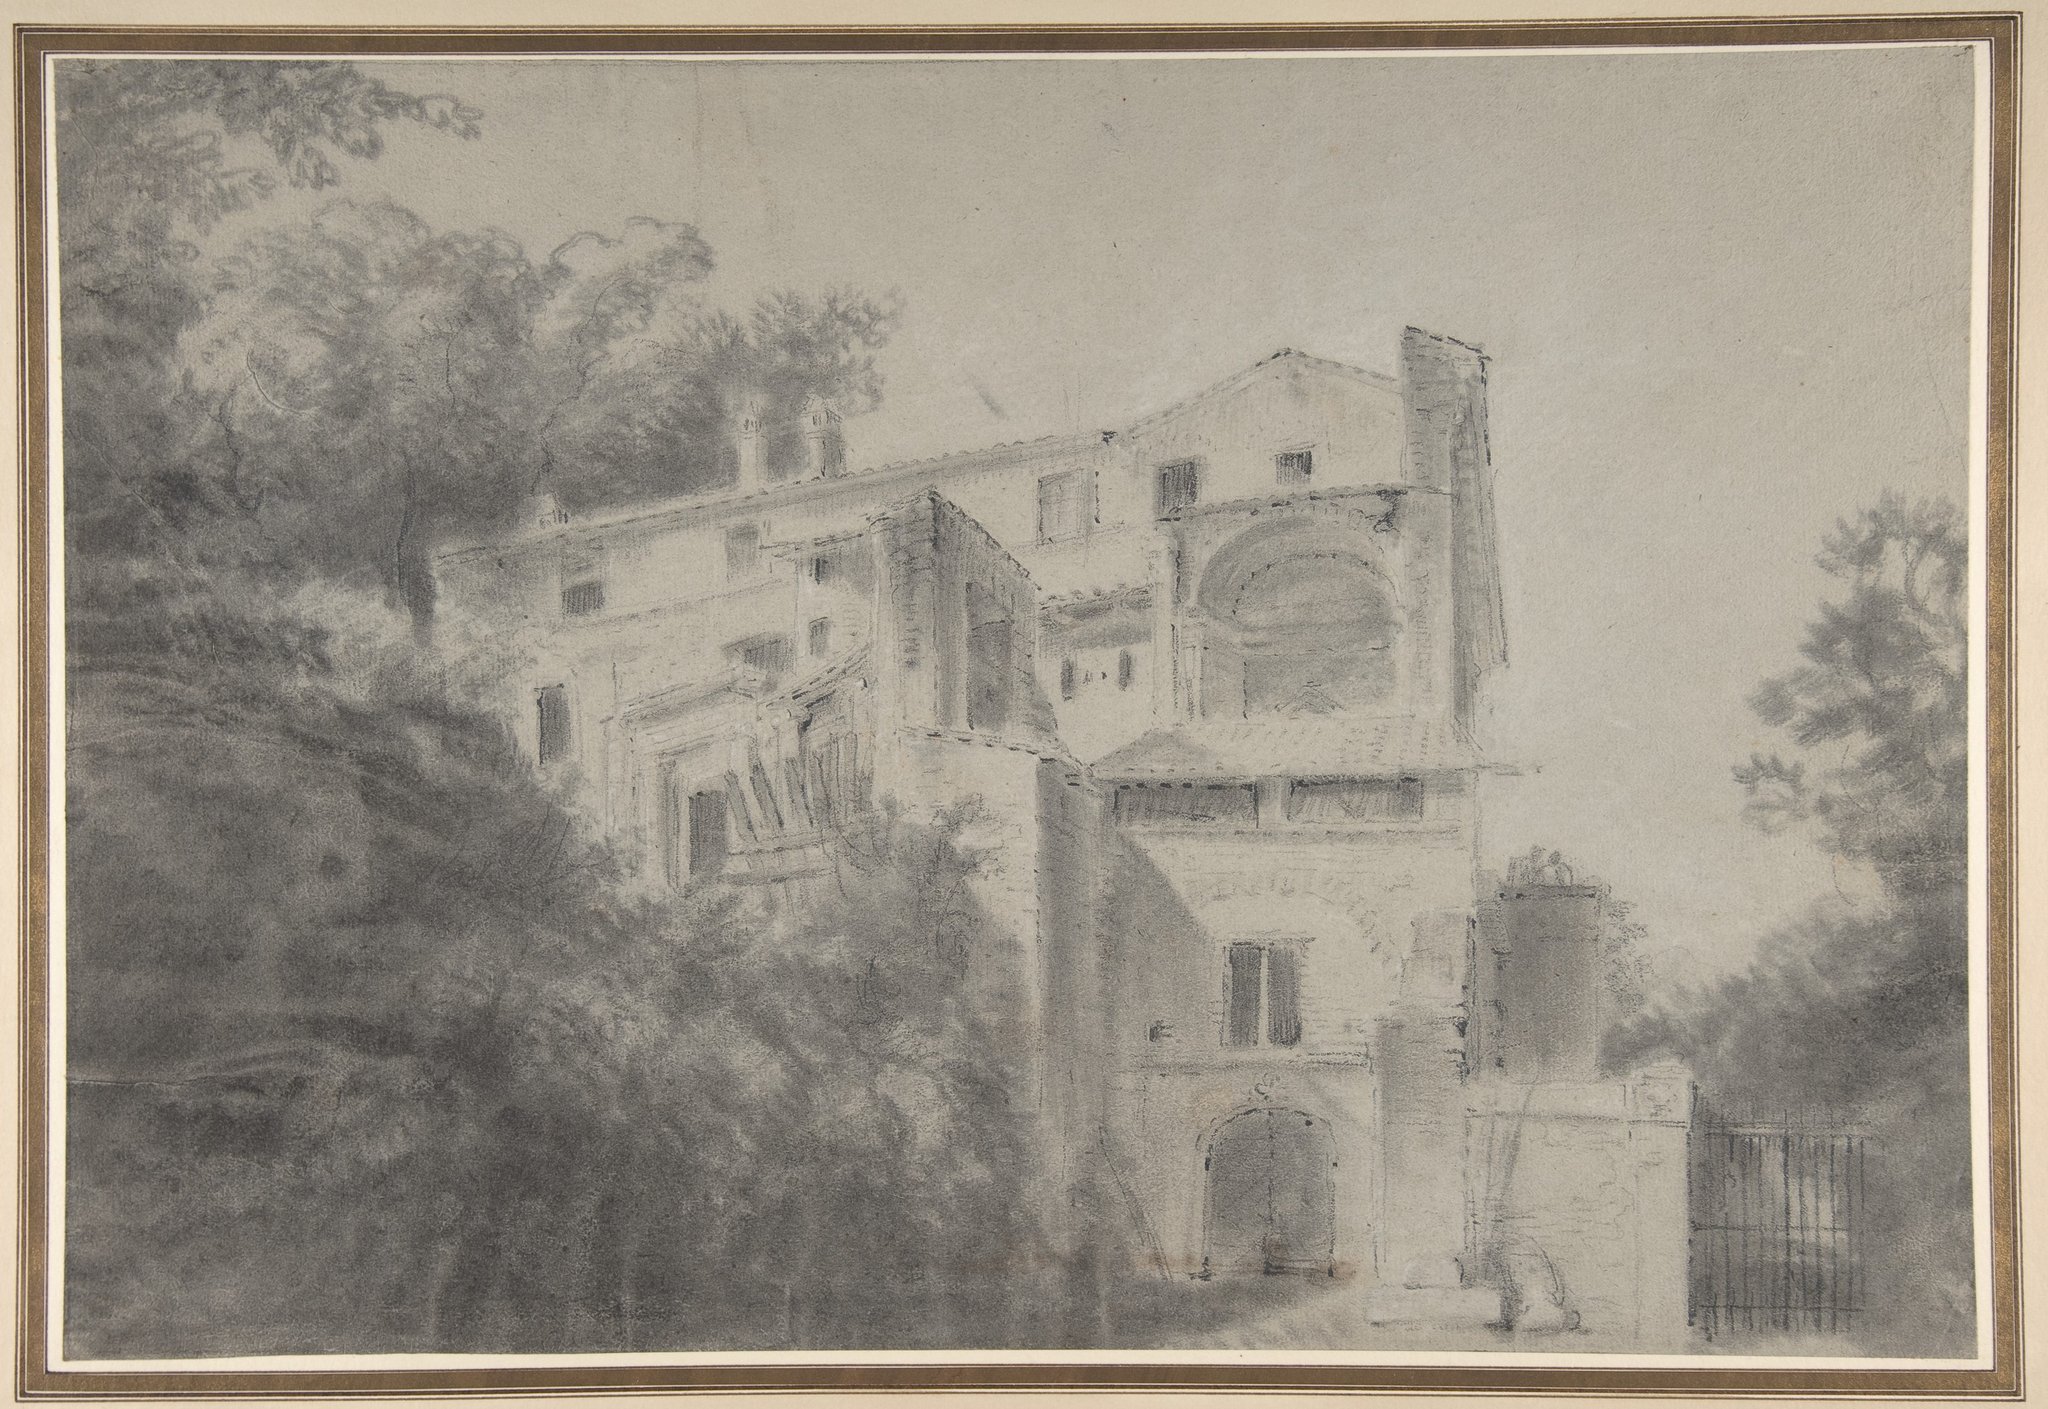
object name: drawing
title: View of the Palazza Madama, Rome (?)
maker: charles michel ange challe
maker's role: artist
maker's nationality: french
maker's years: 1718-1778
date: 1734-1766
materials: chalk, paper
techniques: stumping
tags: buildings